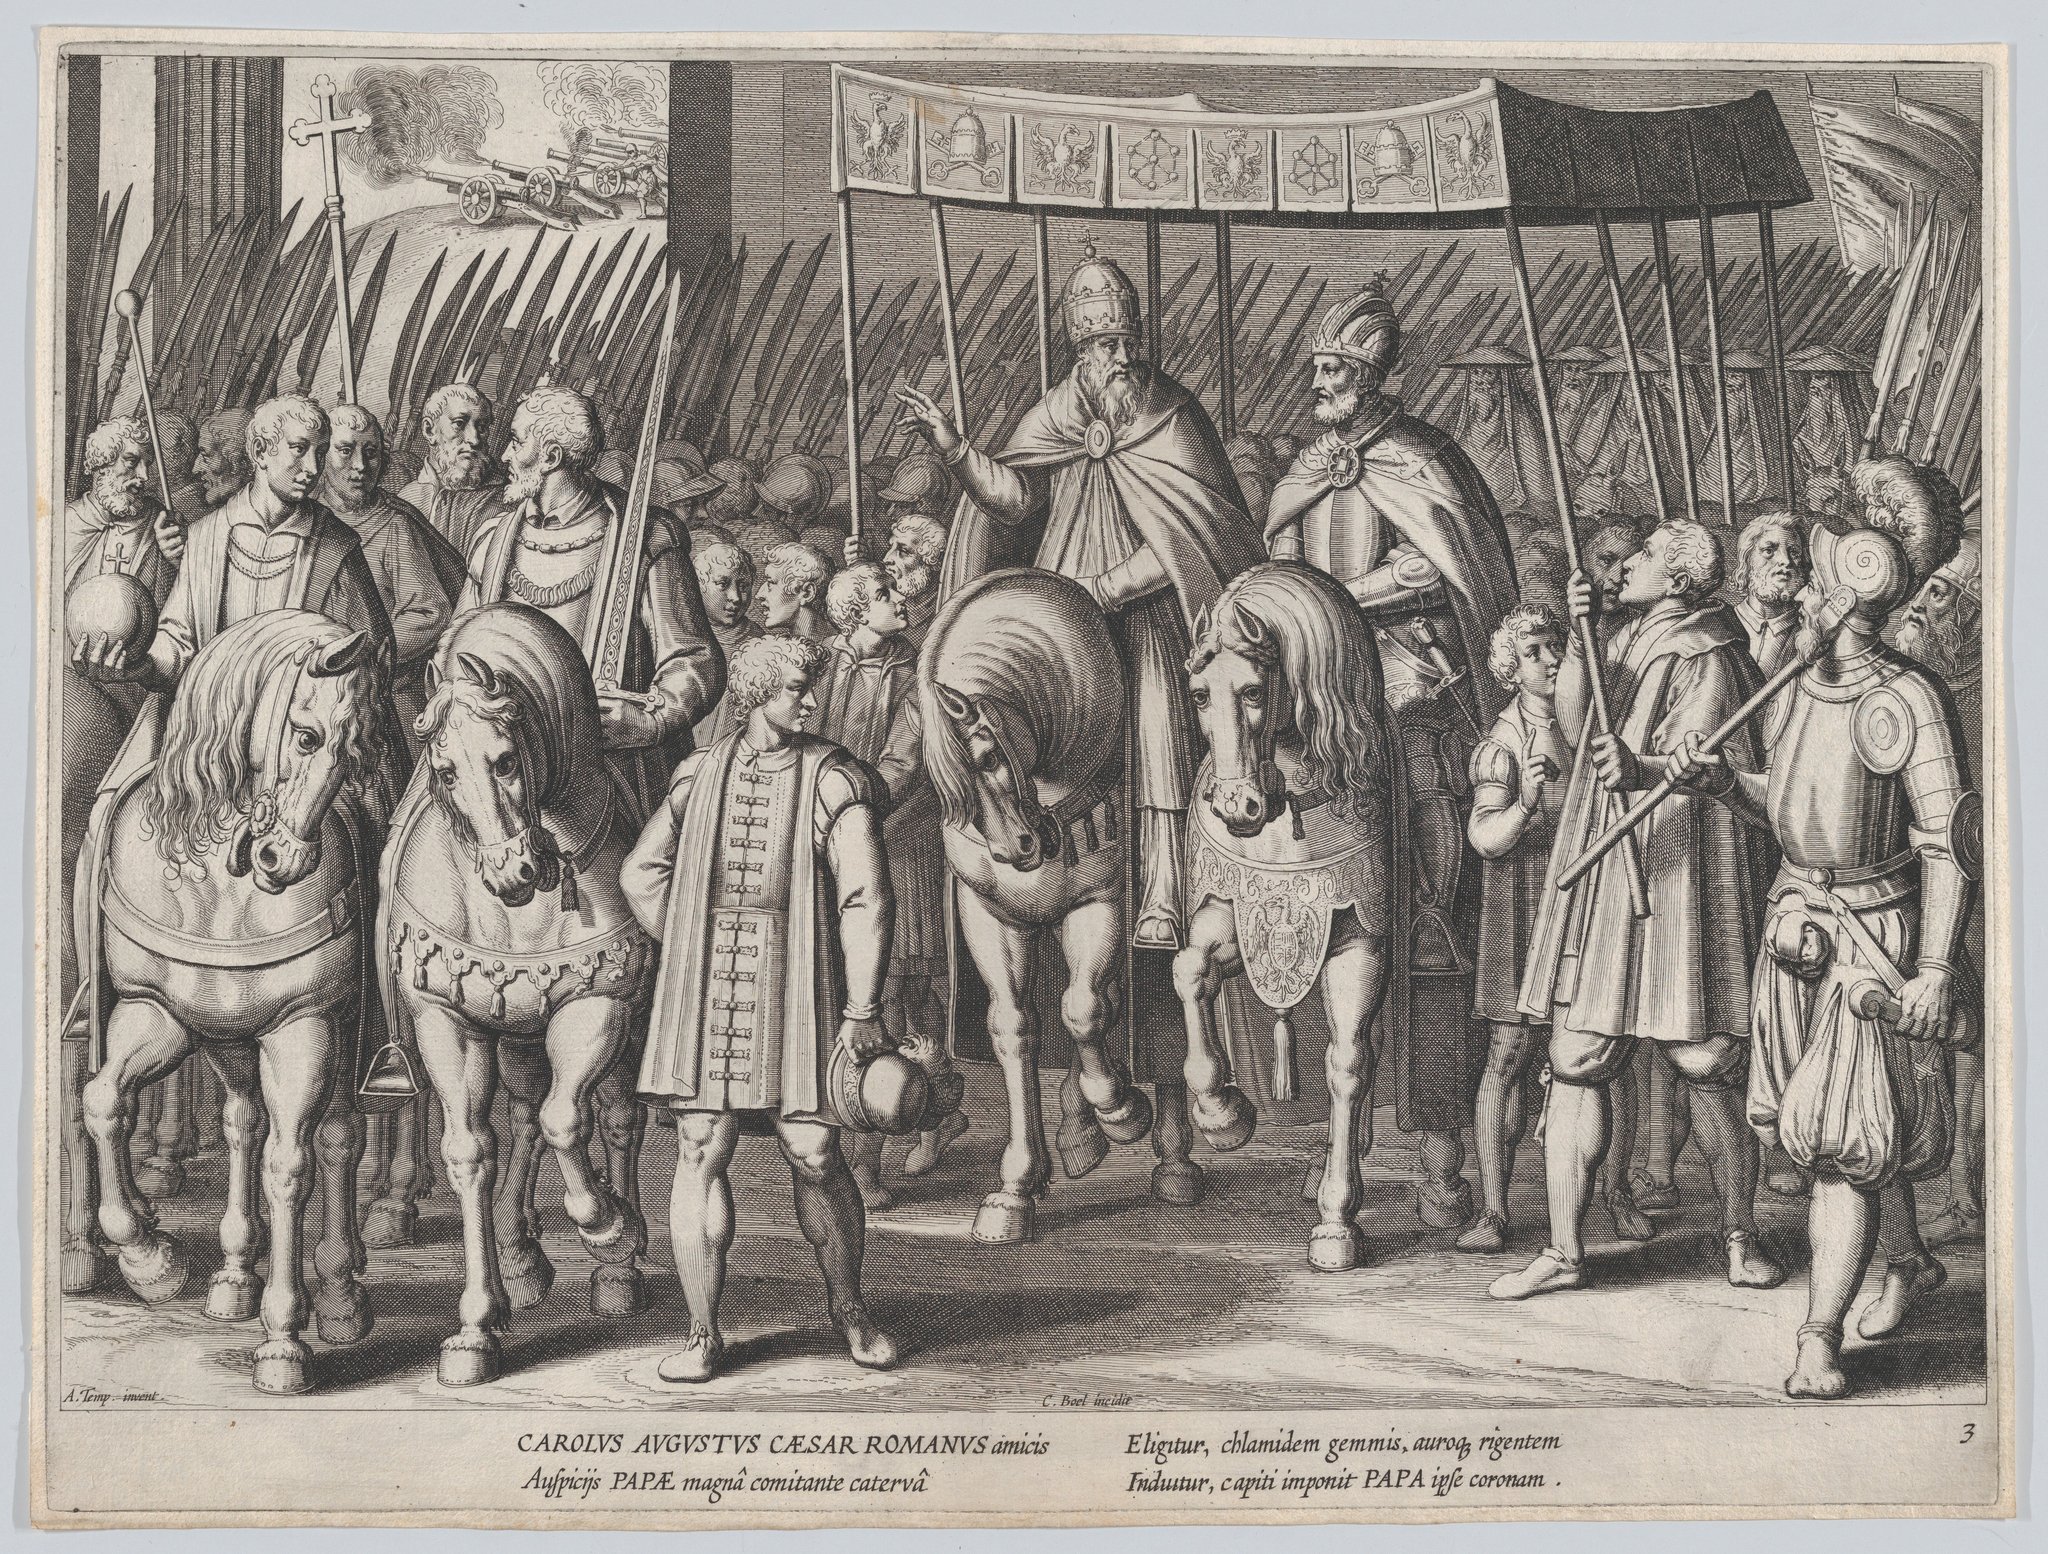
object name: print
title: Plate 3: Charles V Crowned Emperor entering Rome with the Pope, from the Triumphs of Charles V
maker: cornelis boel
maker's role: artist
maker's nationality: netherlandish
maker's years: 1576-1621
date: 1614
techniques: engraving, etching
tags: soldiers,weapons,horses,popes